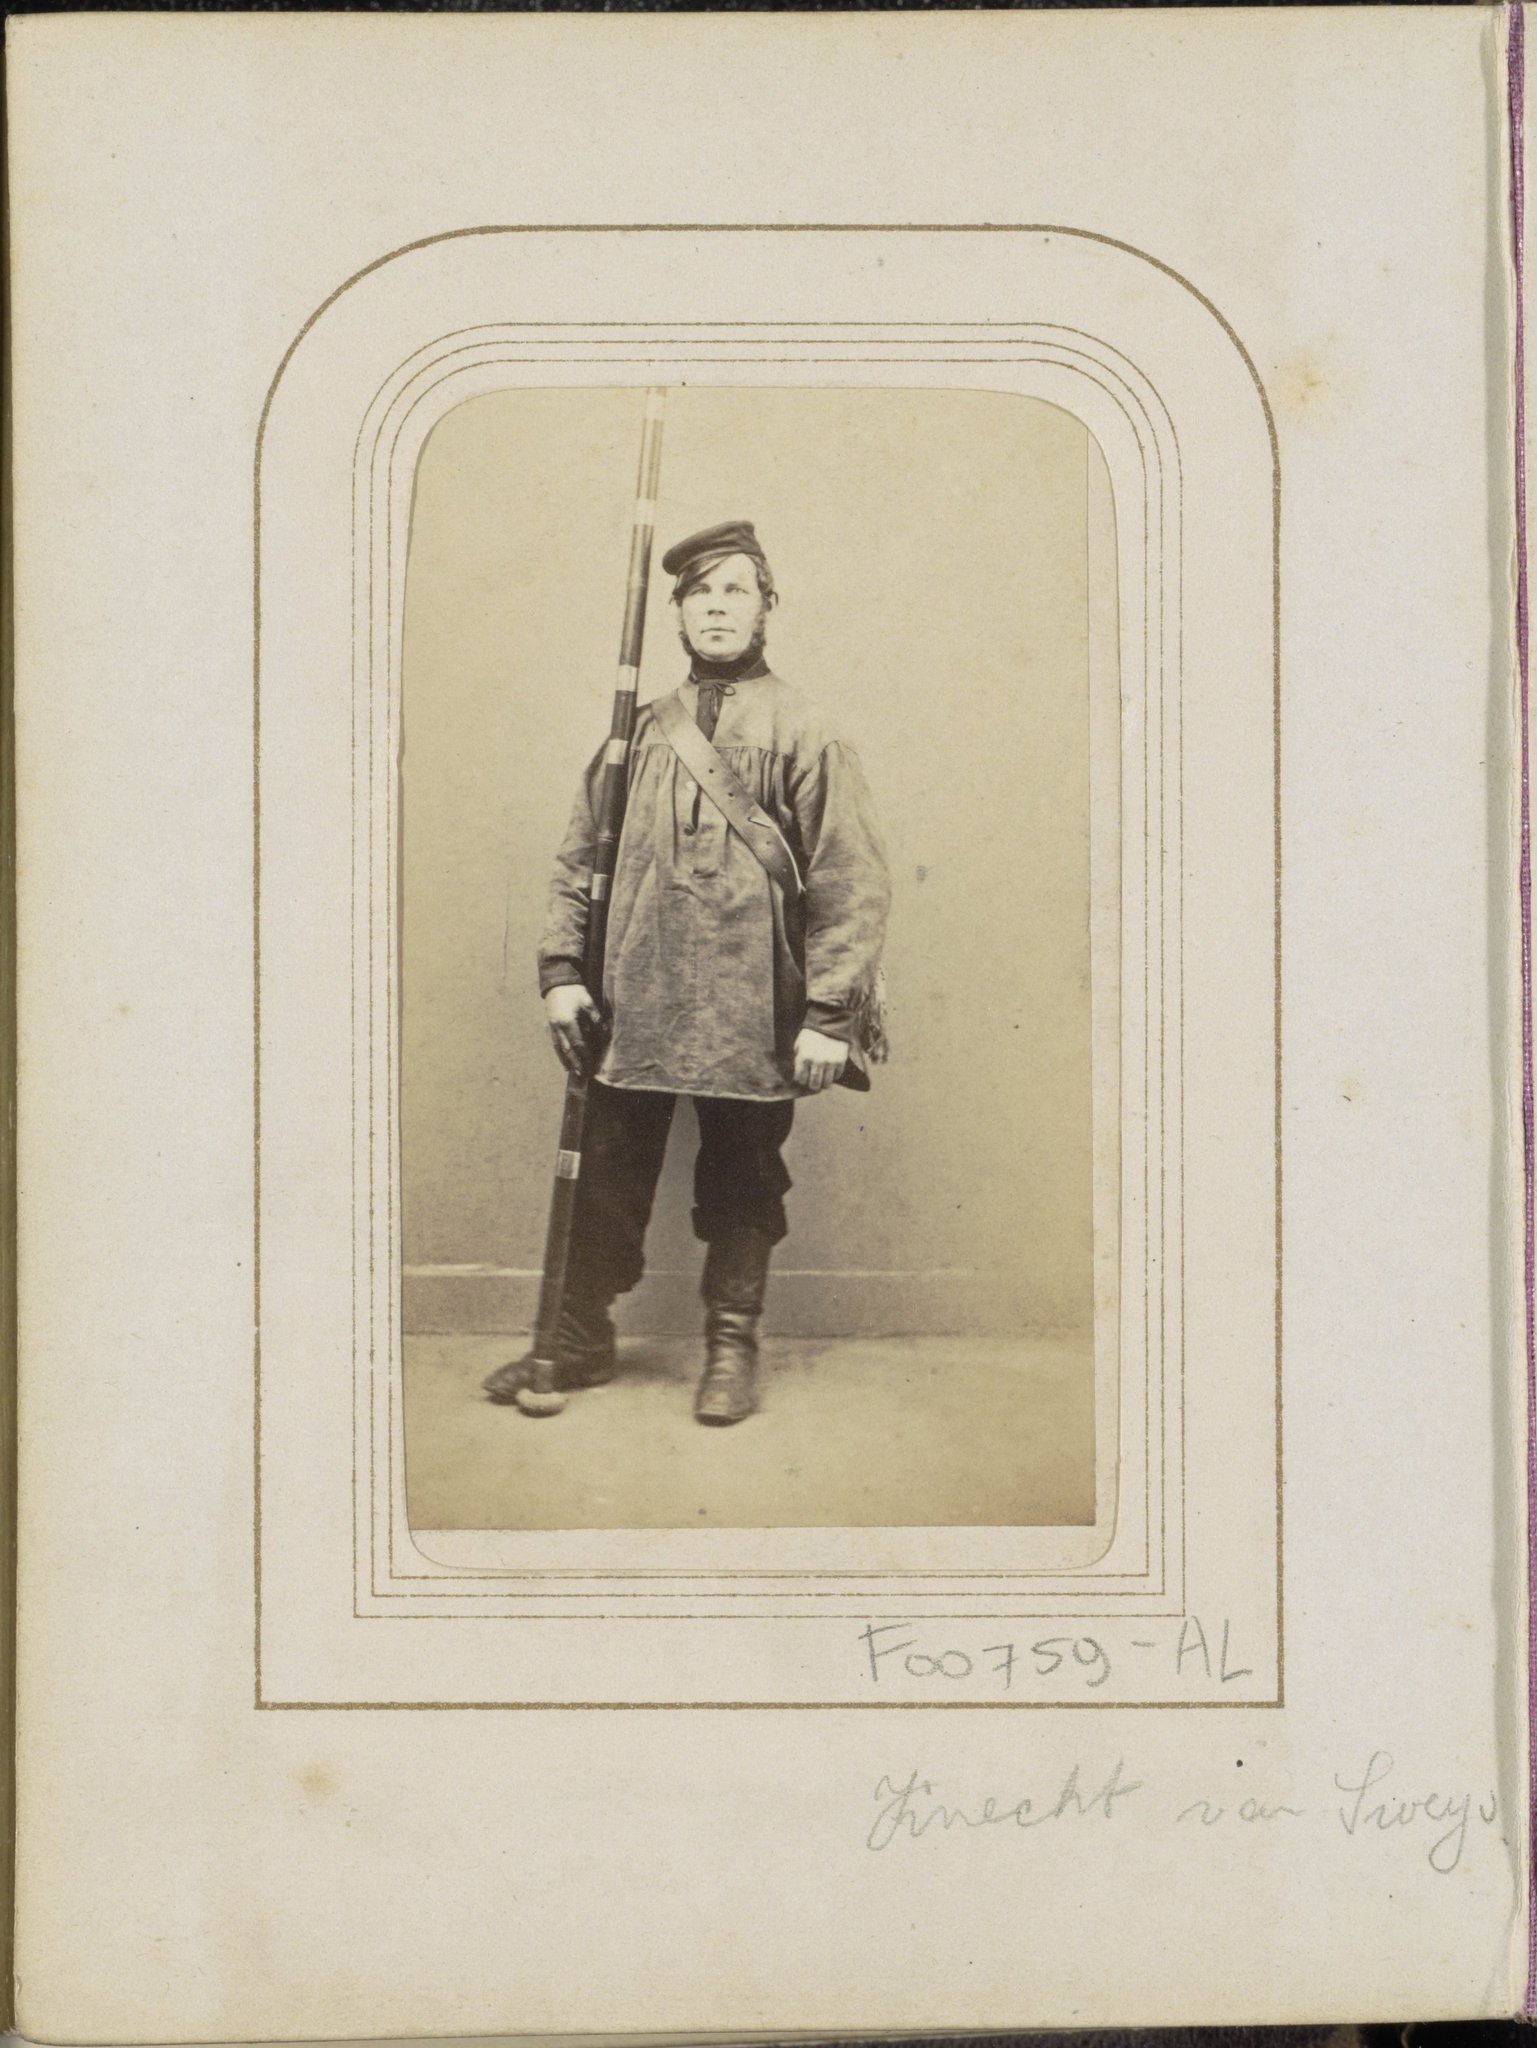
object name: photograph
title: Portret van een man aangeduid als knecht van Sweys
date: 1860-1875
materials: cardboard, paper, photographic support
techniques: albumen print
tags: studio requisites ~ photographer, historical persons, clothes for special purposes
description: Onderdeel van Fotoalbum van een Nederlandse familie met 50 cartes-de-visite.